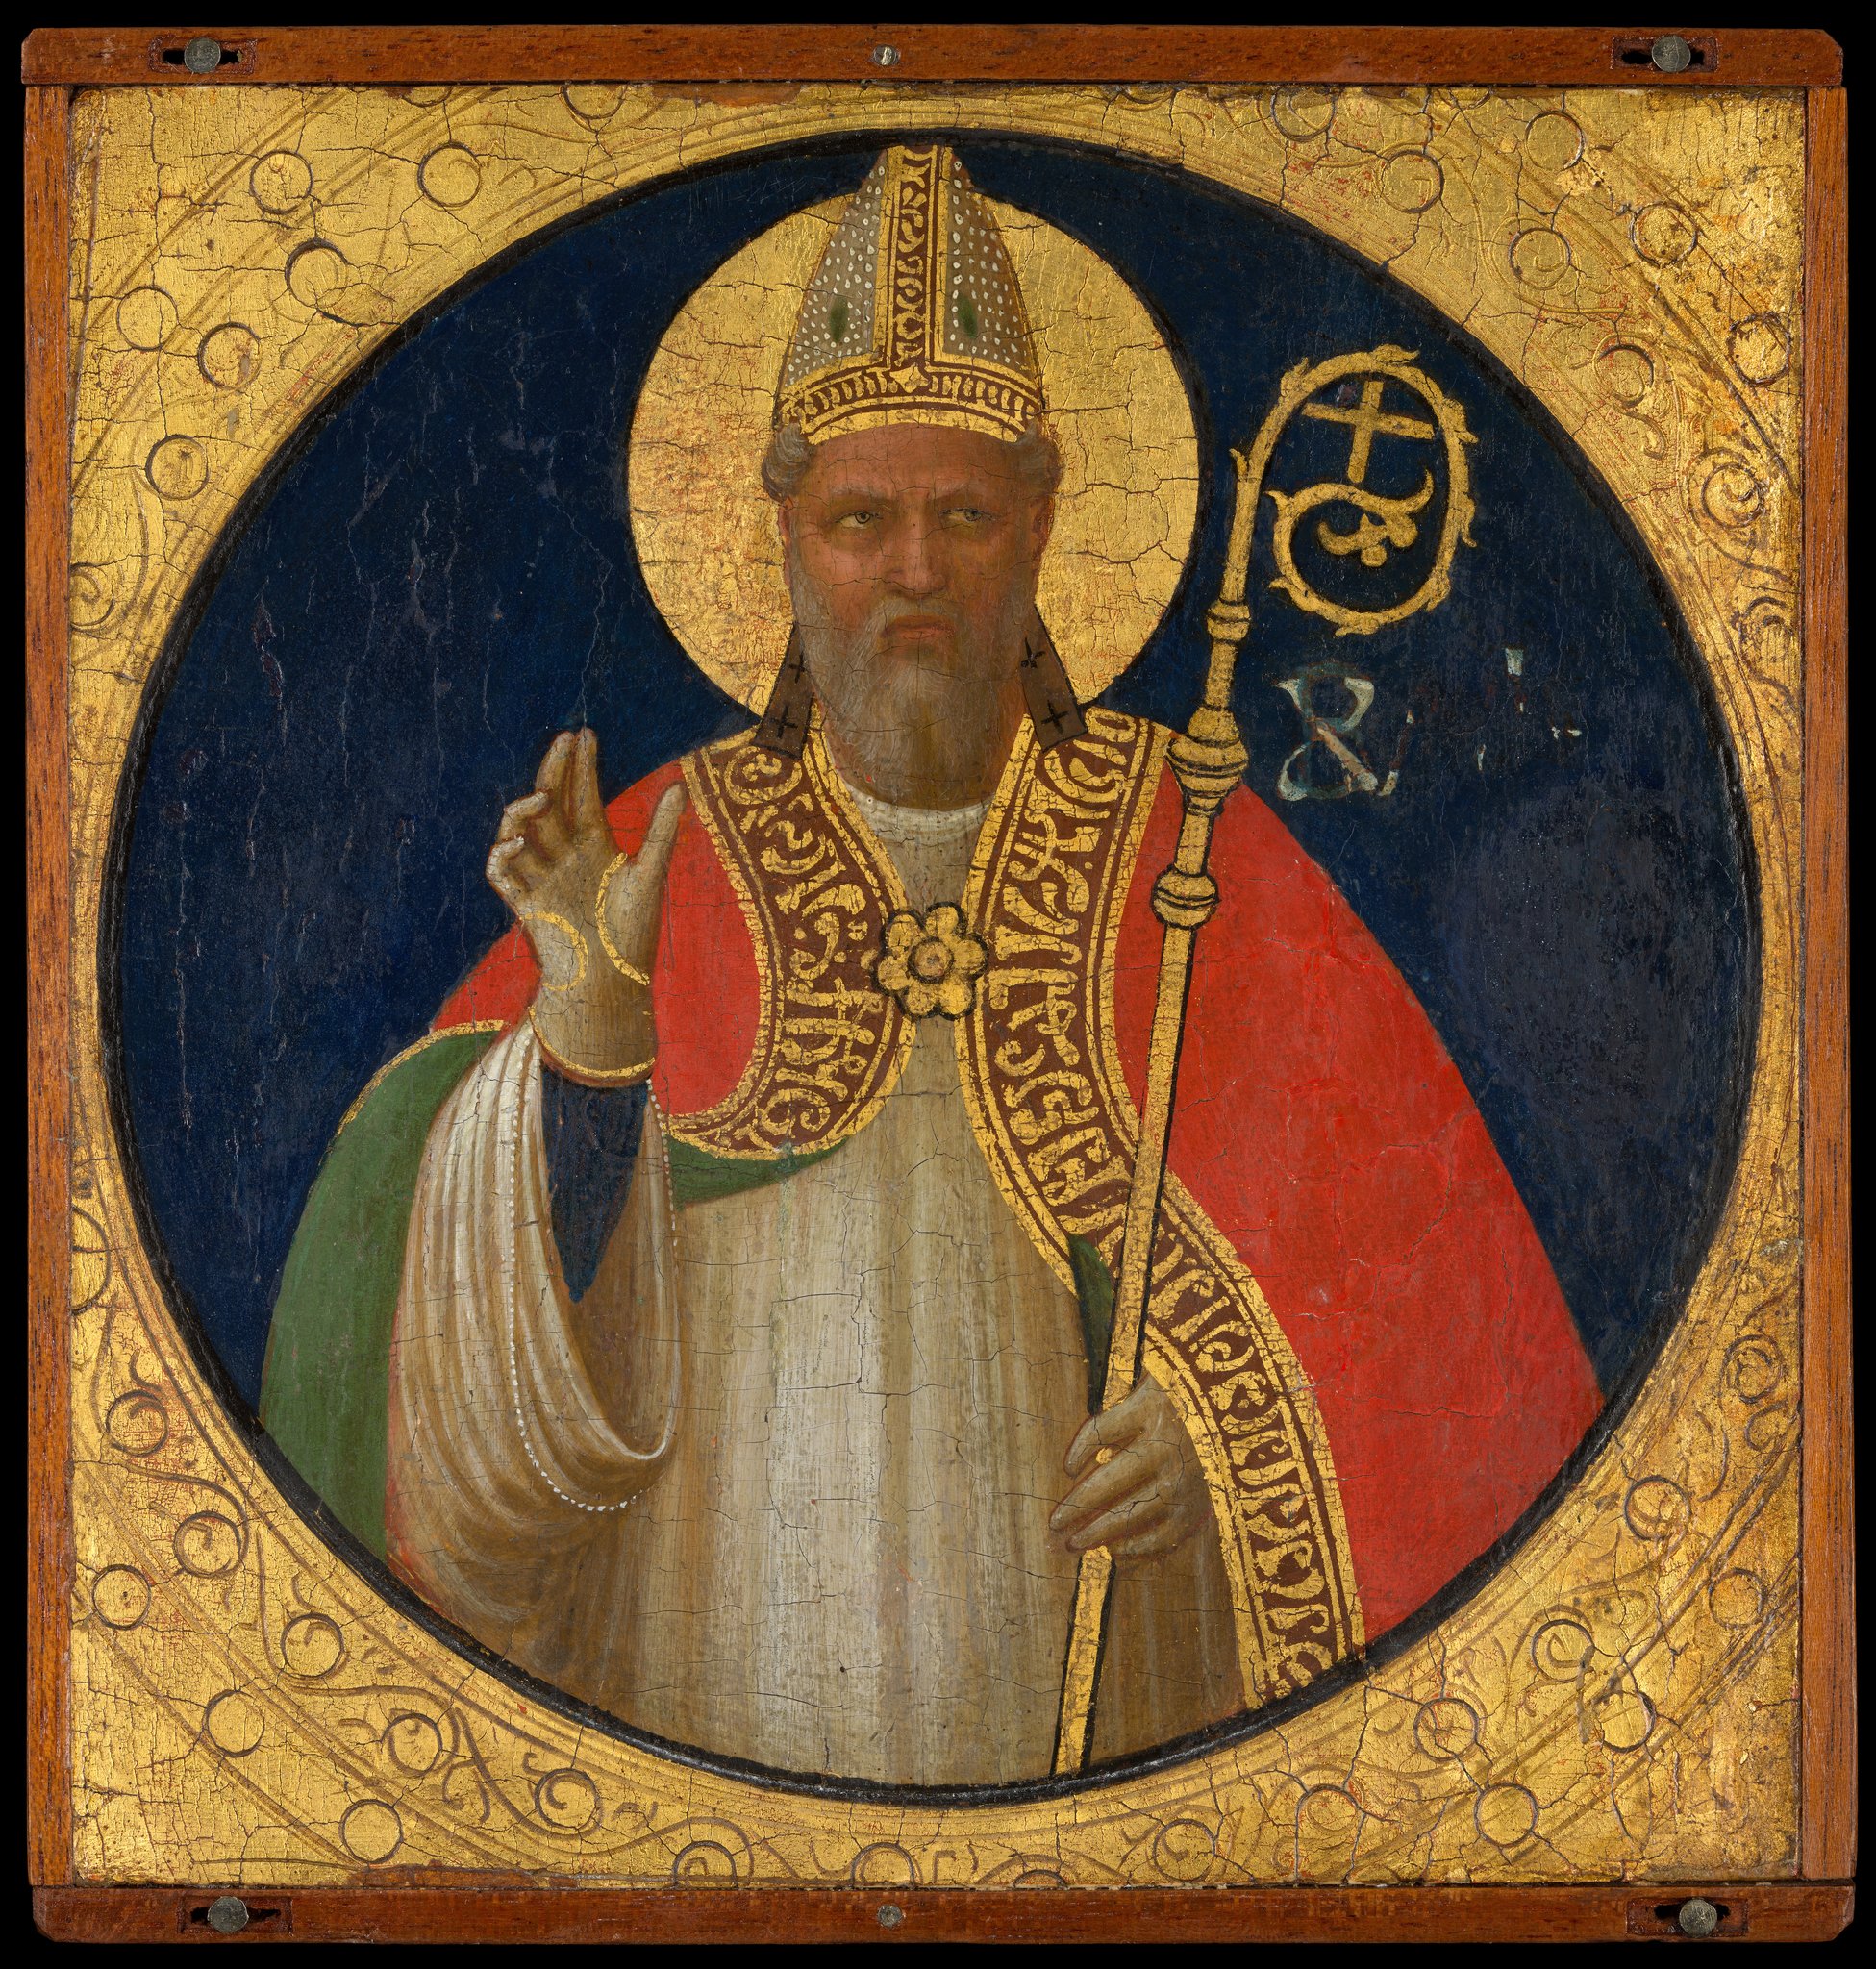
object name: painting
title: Saint Alexander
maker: fra angelico (guido di pietro)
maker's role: artist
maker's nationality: italian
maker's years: 1395-1455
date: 1425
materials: gold leaf, paint, wood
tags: bishops,croziers,miter